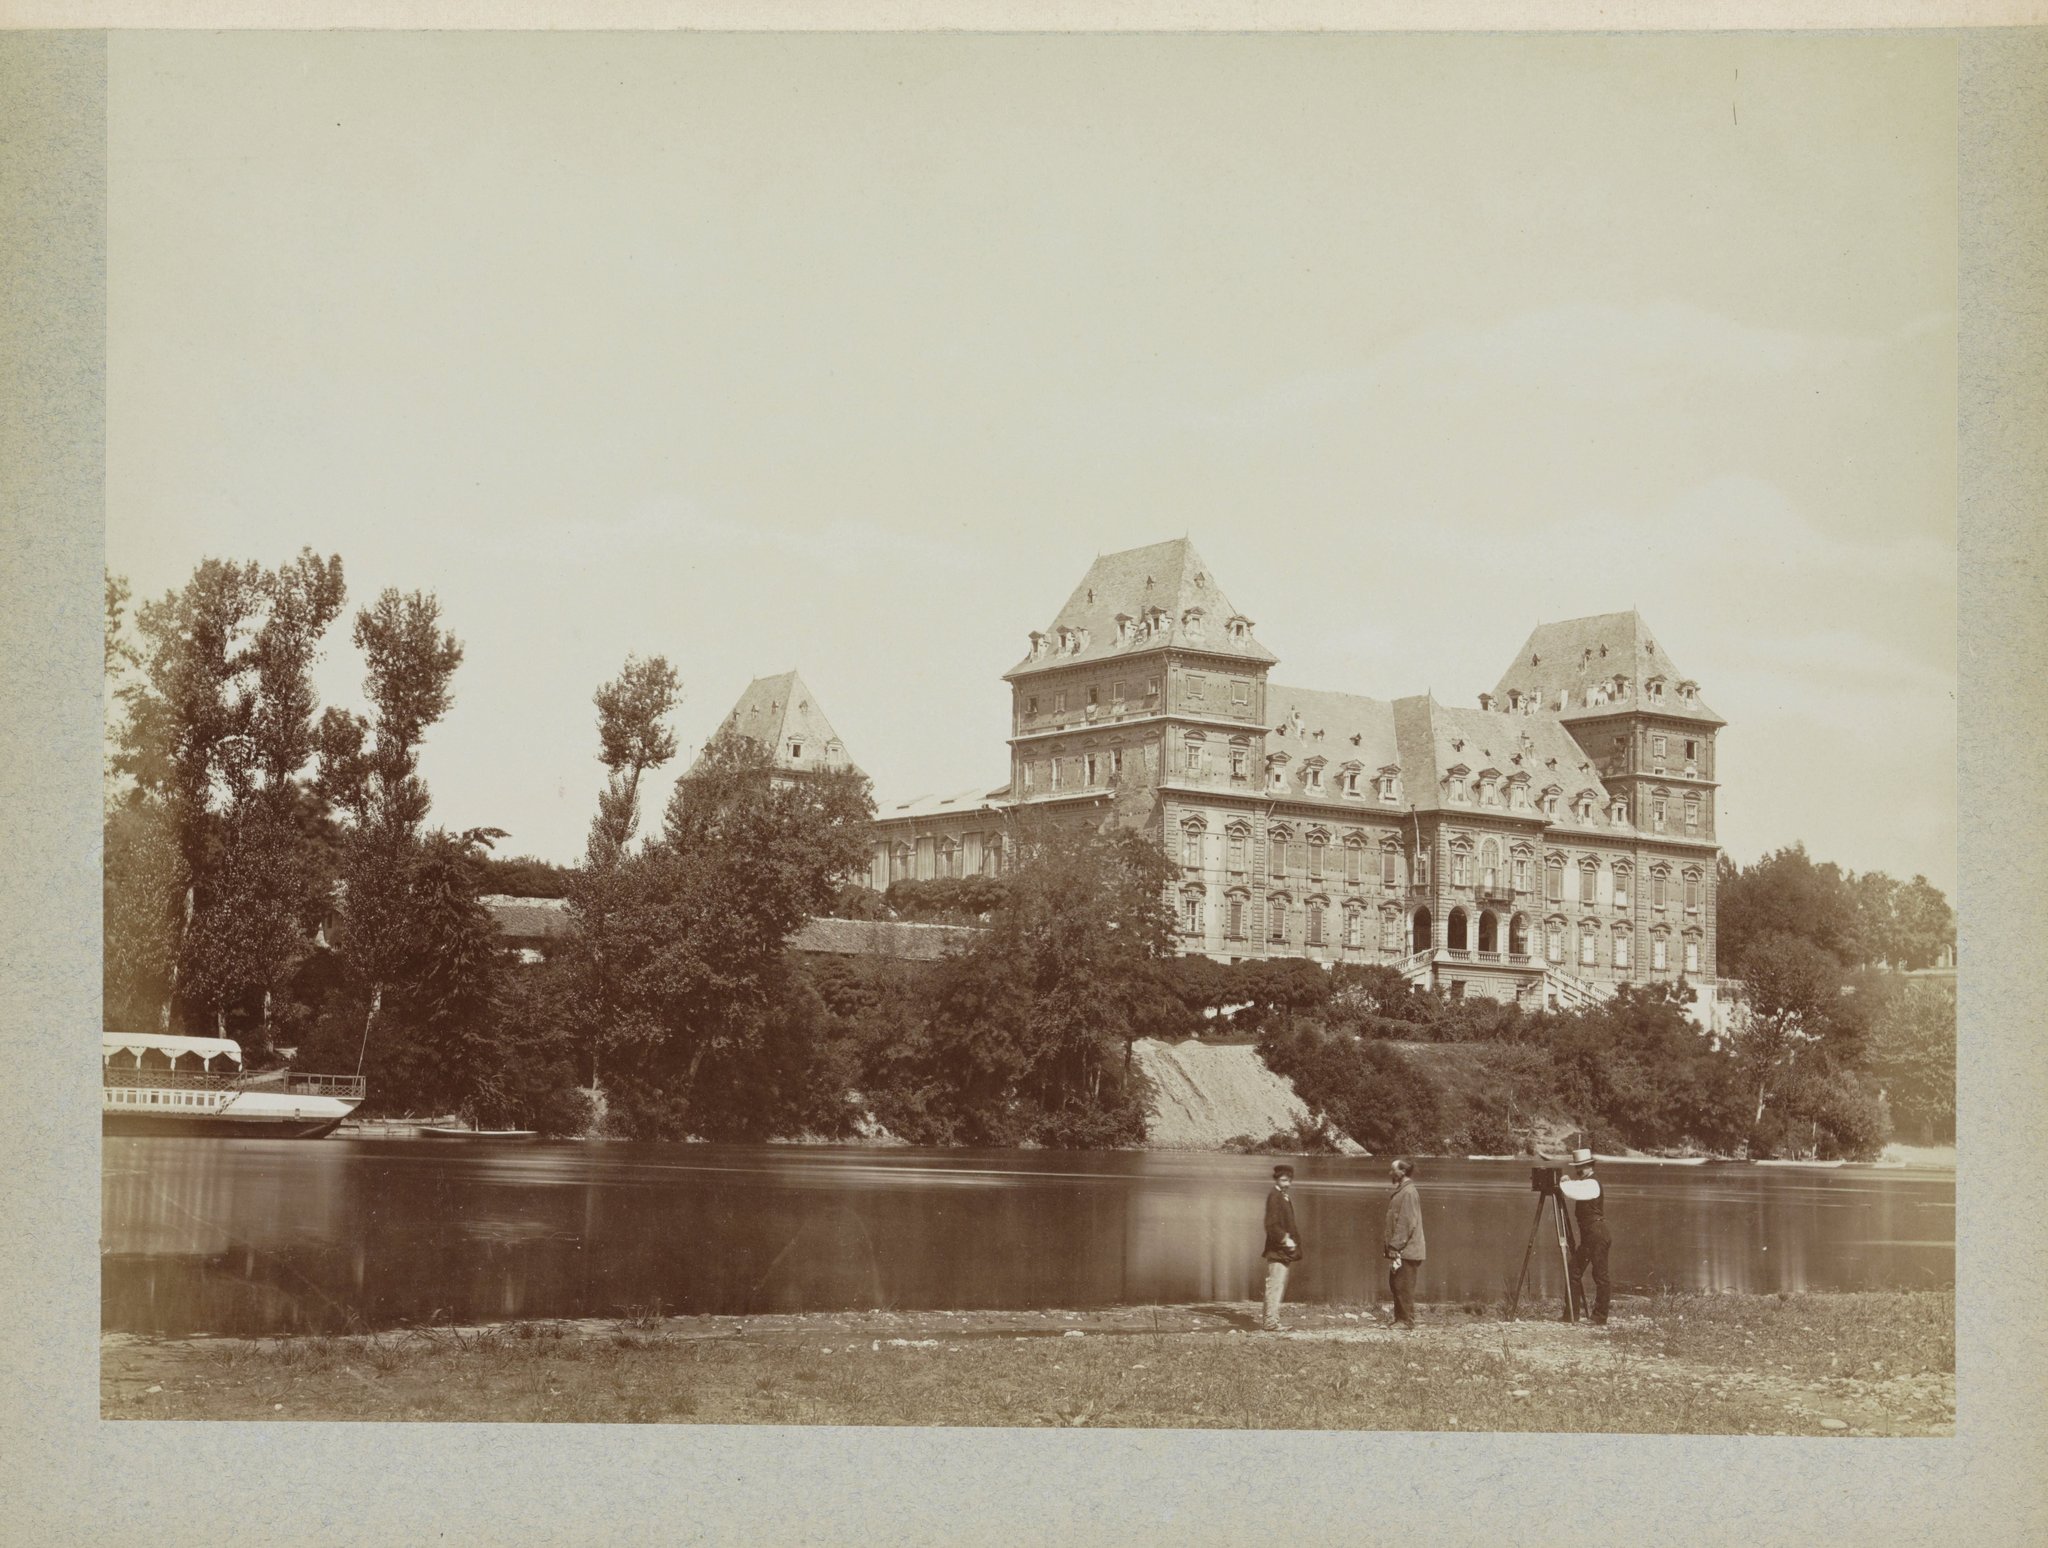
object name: photograph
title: Gezicht op een paleis aan een rivier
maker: Anonymous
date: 1885-1900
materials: paper, photographic support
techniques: albumen print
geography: france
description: Gezicht op een paleis aan een rivier, Italië (?). Op de voorgrond is een fotograaf bezig met fotograferen.